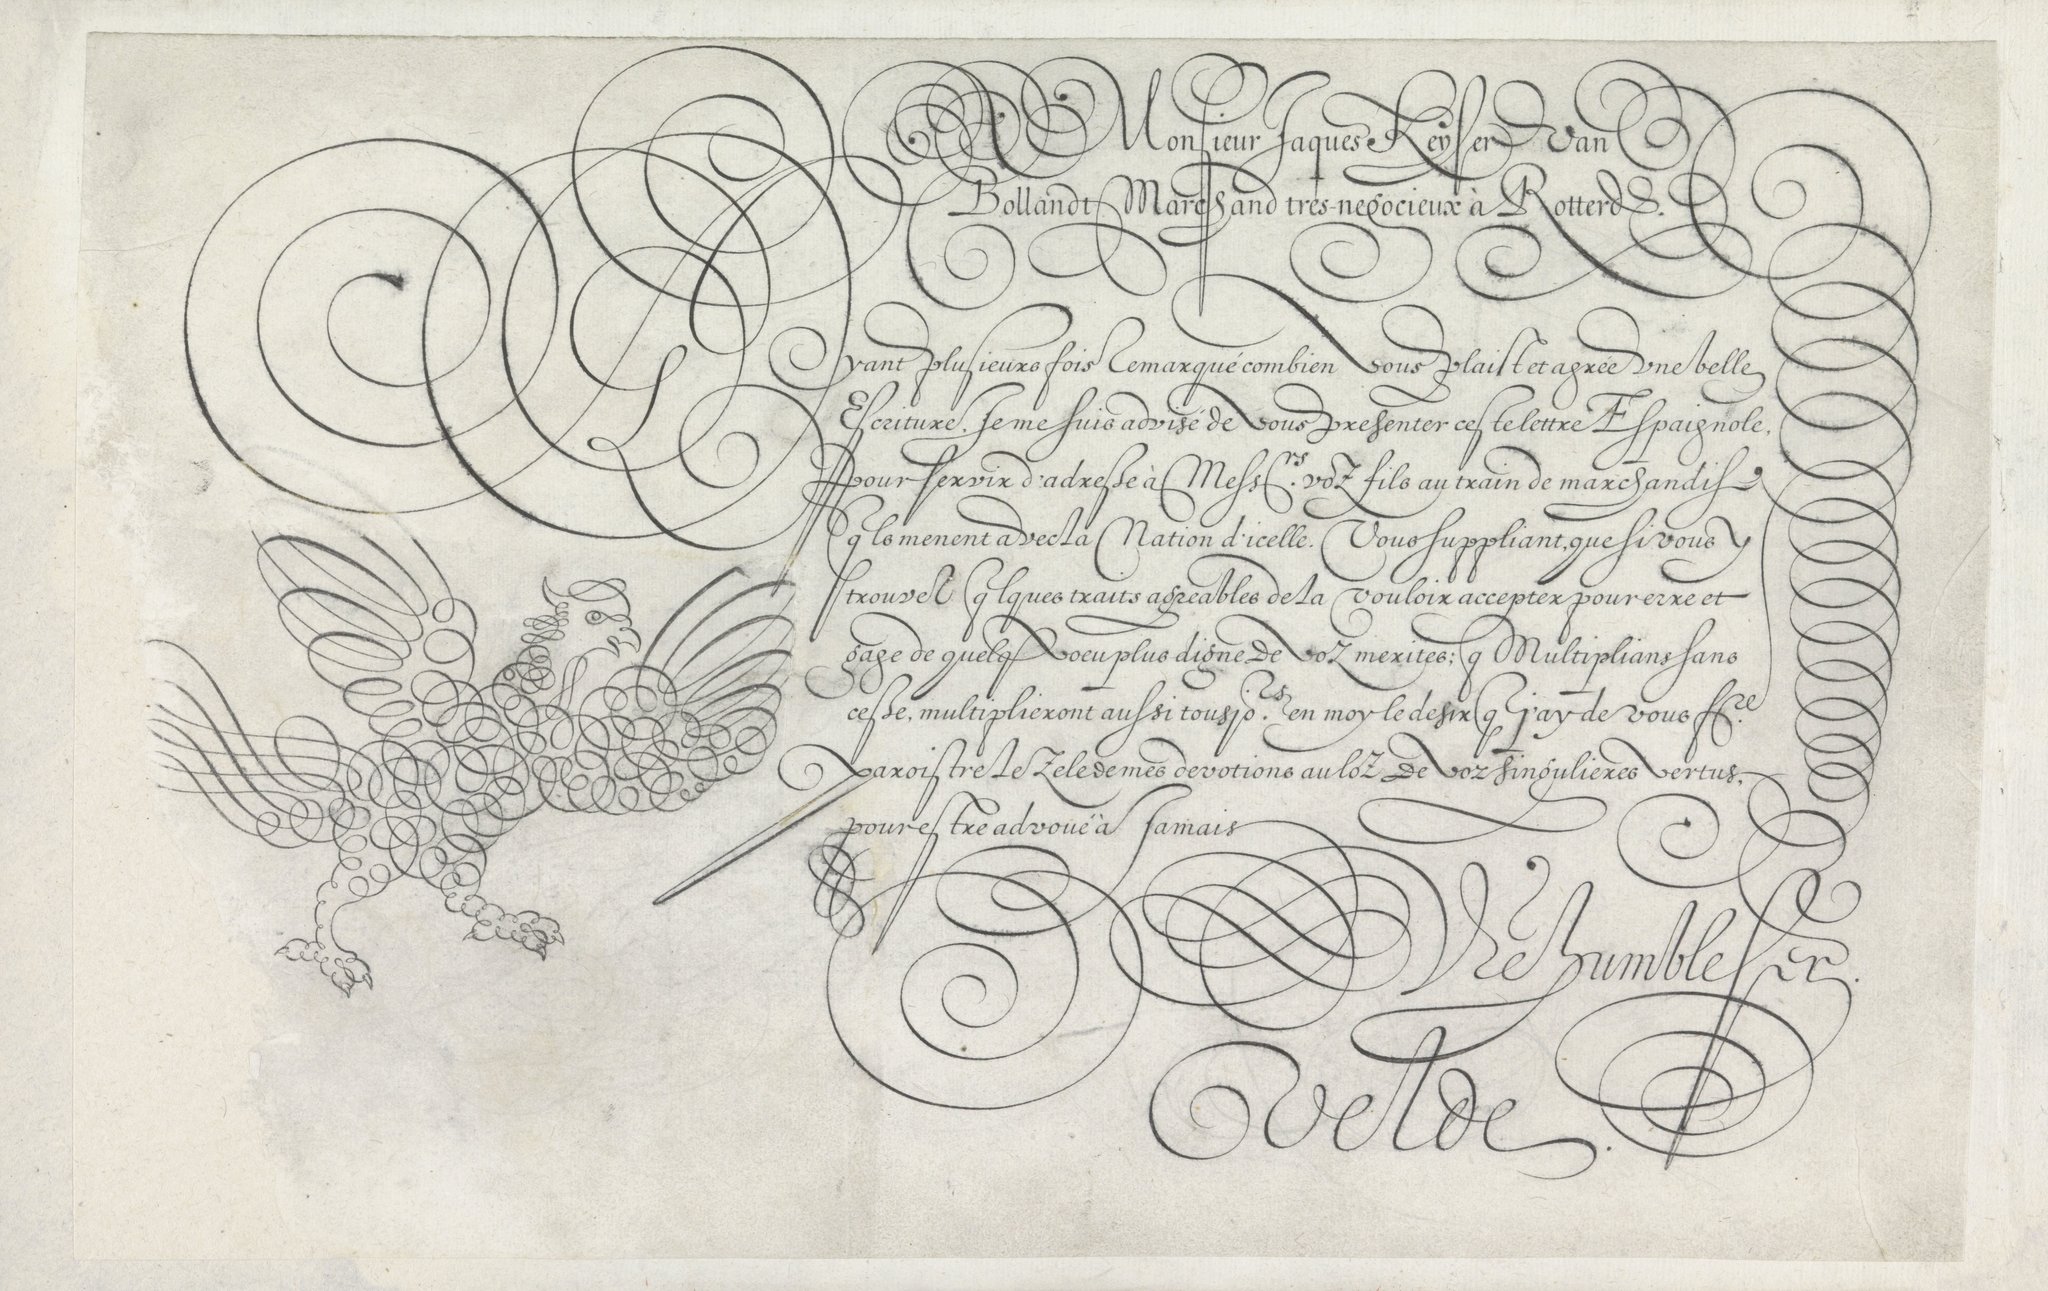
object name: album leaf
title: Spieghel der schrijfkonste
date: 1605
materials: ink, paper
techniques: calligraphy, pen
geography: rotterdam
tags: calligraphy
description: Kalligrafische tekening met de aanhef: A monsieur Jacques Keyser van Bollandt marchand tres negocieux à Rotterd[am]. Daaronder negen regels tekst in het Frans: Ayant plusieurs ... Aan de linkerkant een adelaar in krulwerk. De tekening maakt deel uit van een album.